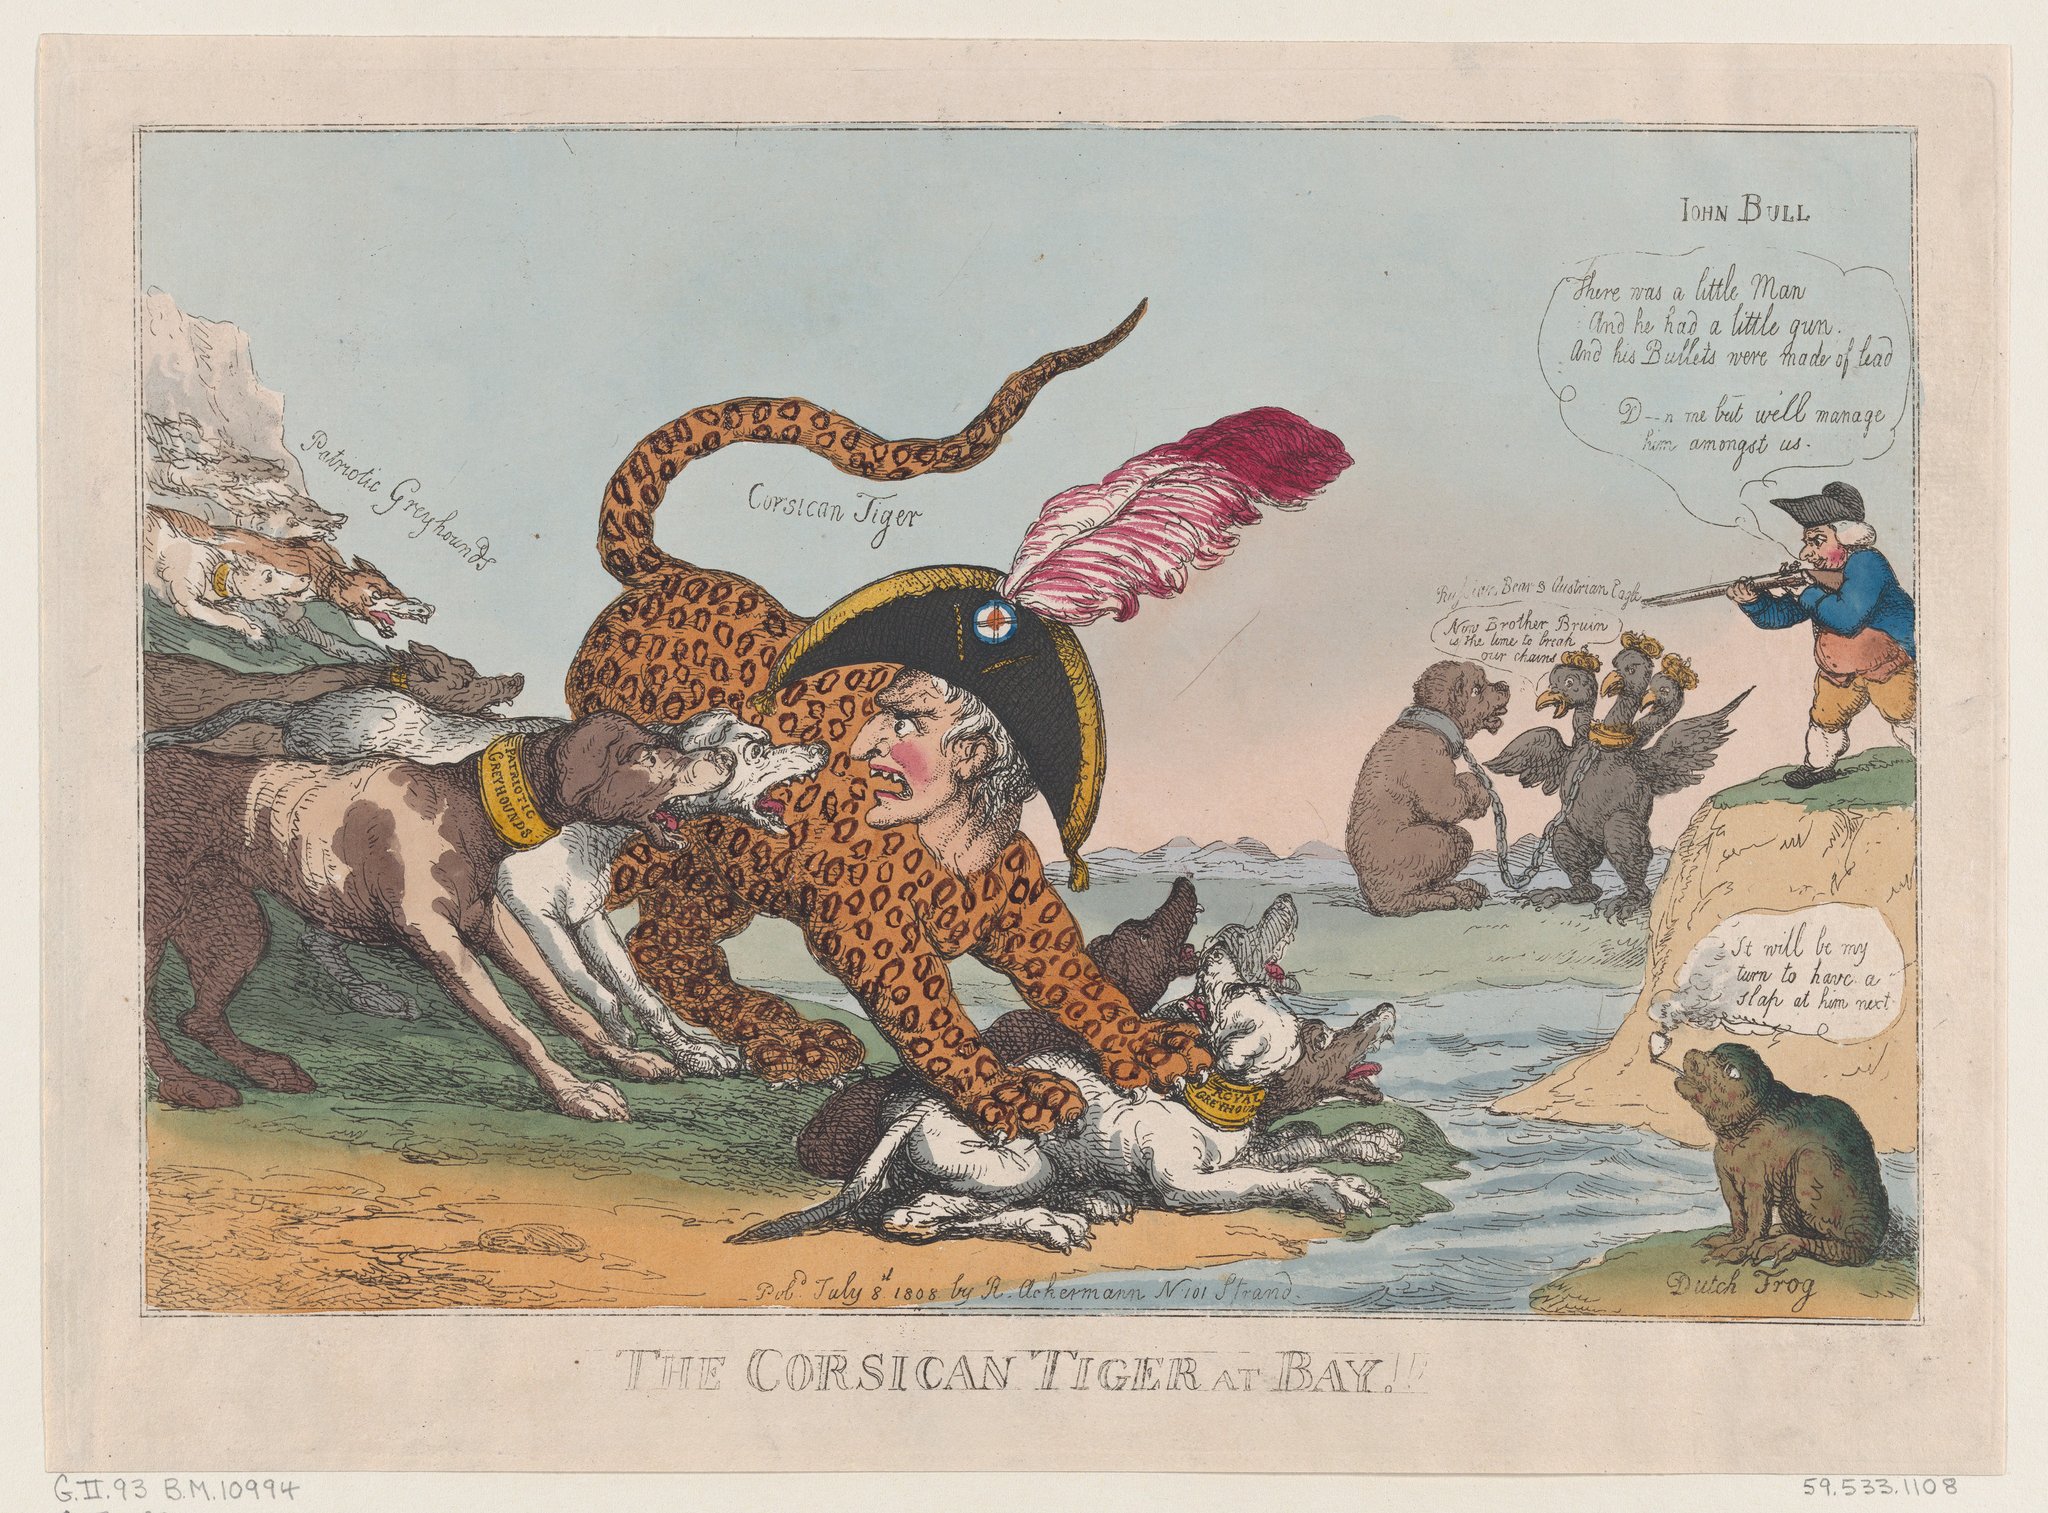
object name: print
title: The Corsican Tiger at Bay!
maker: thomas rowlandson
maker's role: artist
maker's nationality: british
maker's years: 1757-1827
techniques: etching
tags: satire,napoleon i,men,dogs,politics